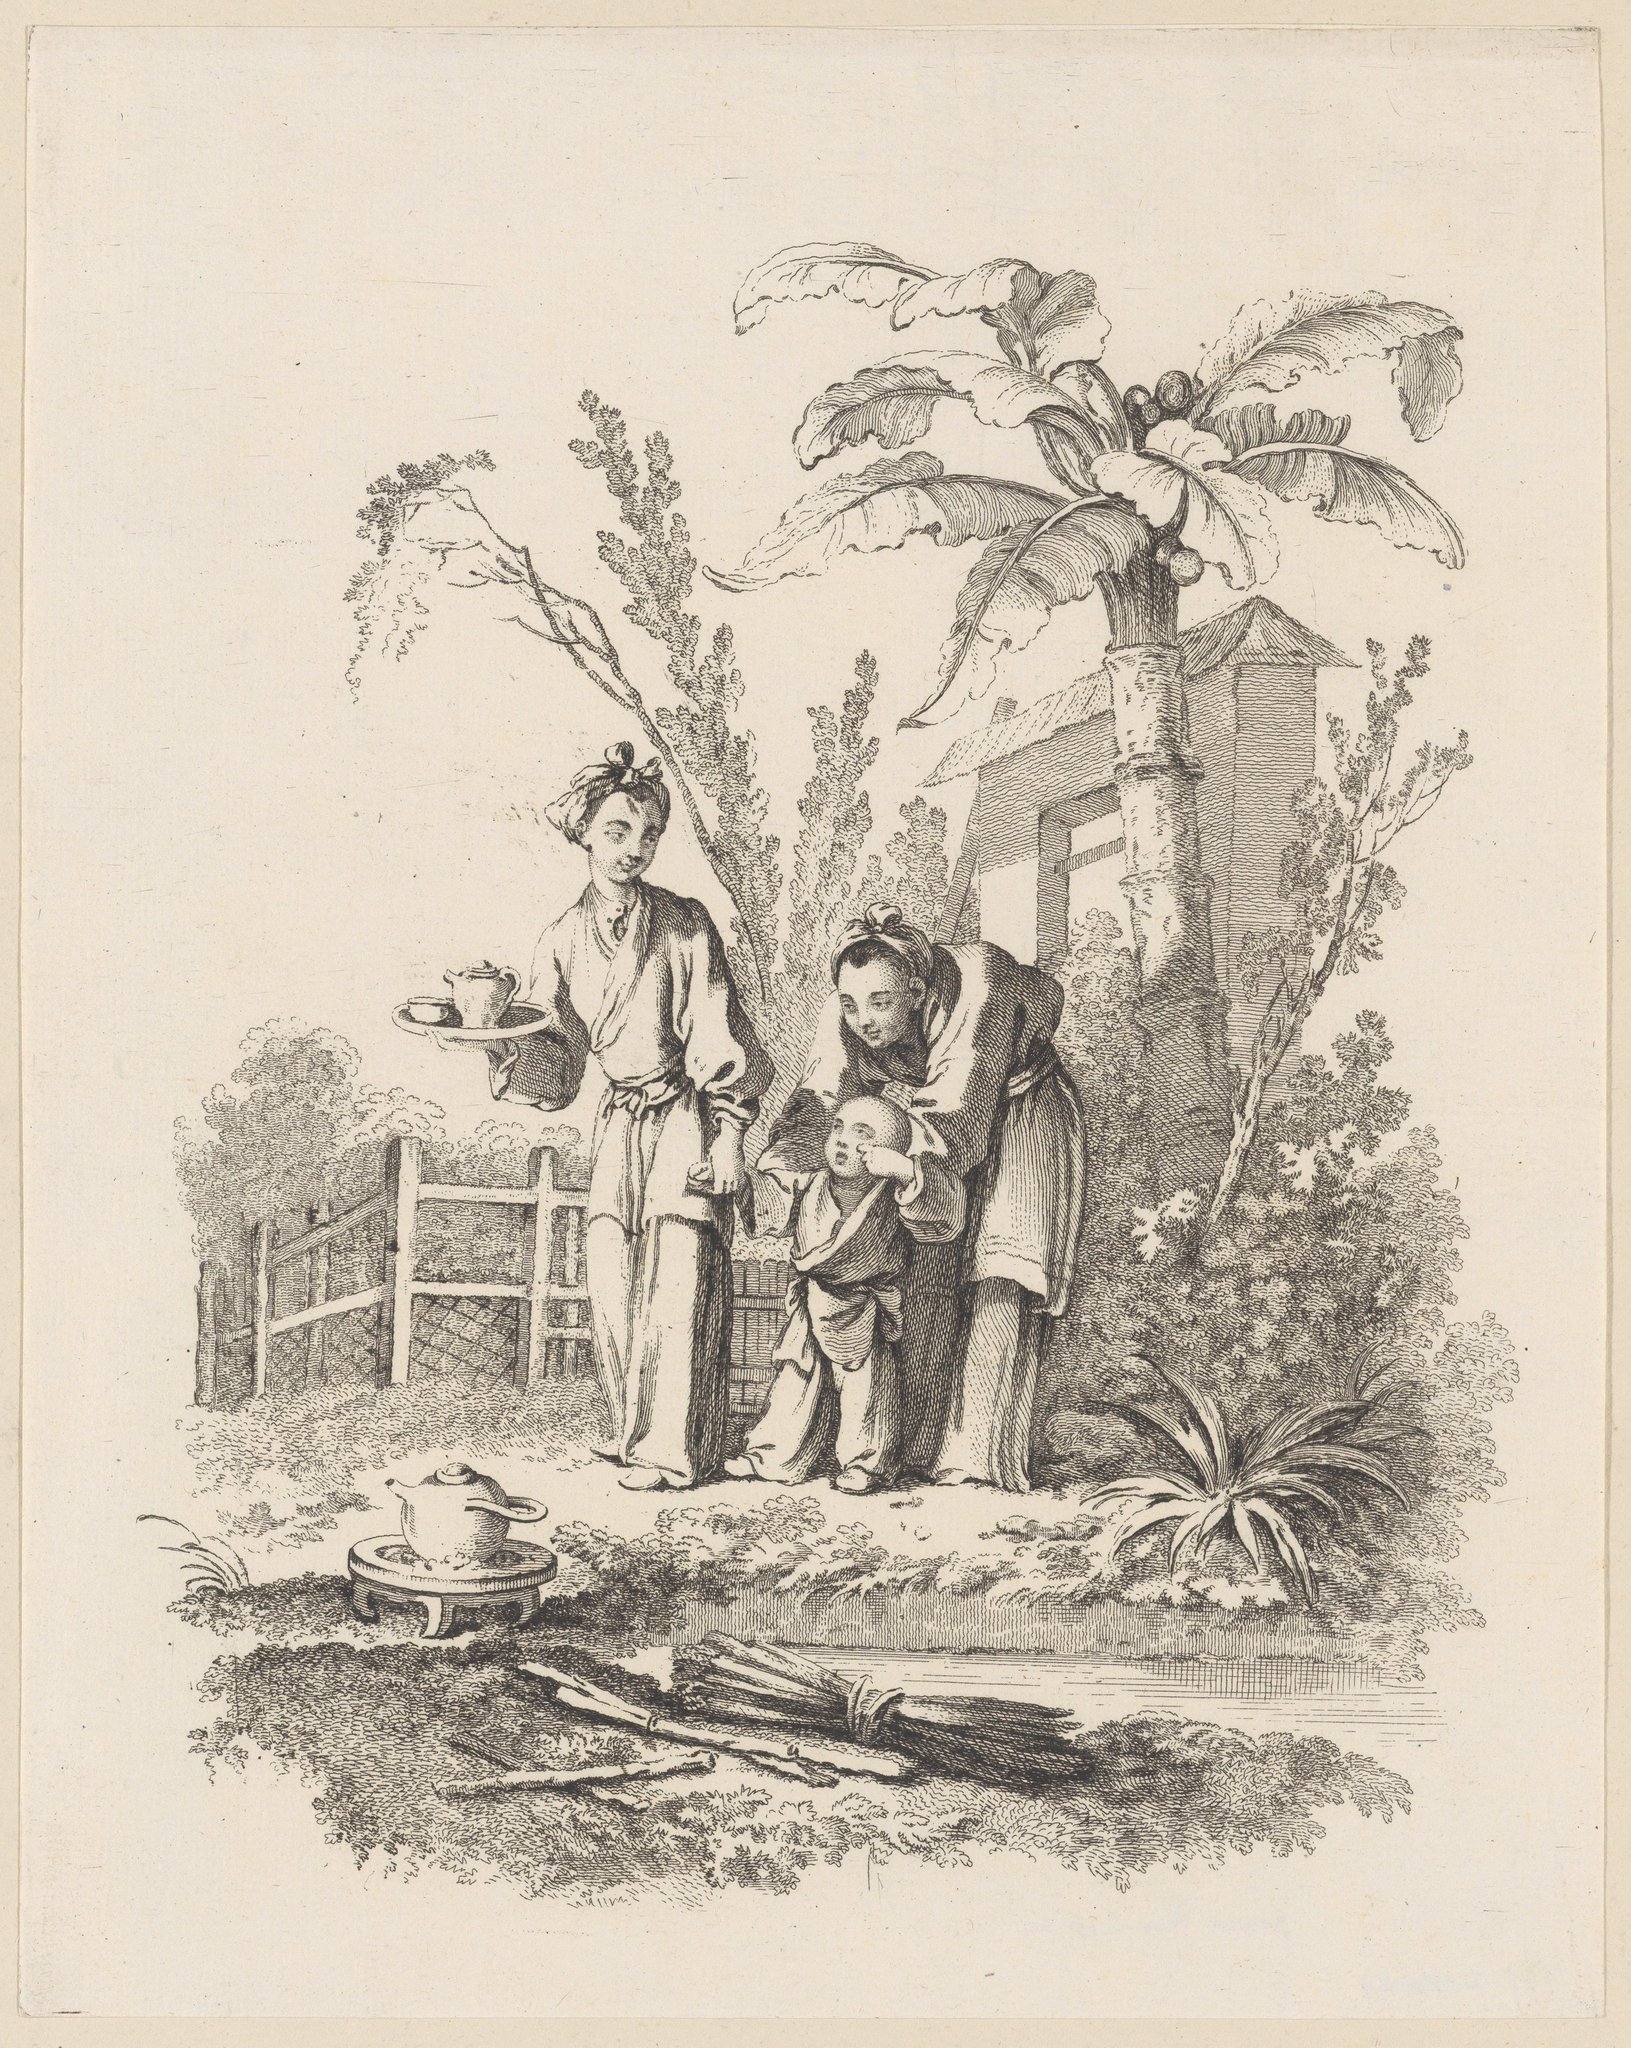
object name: print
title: Two Women Leading a Child toward a Teapot on a Table near a Pond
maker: gabriel huquier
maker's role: artist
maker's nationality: french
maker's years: 1695-1772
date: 1742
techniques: engraving, etching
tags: children,women,teapots